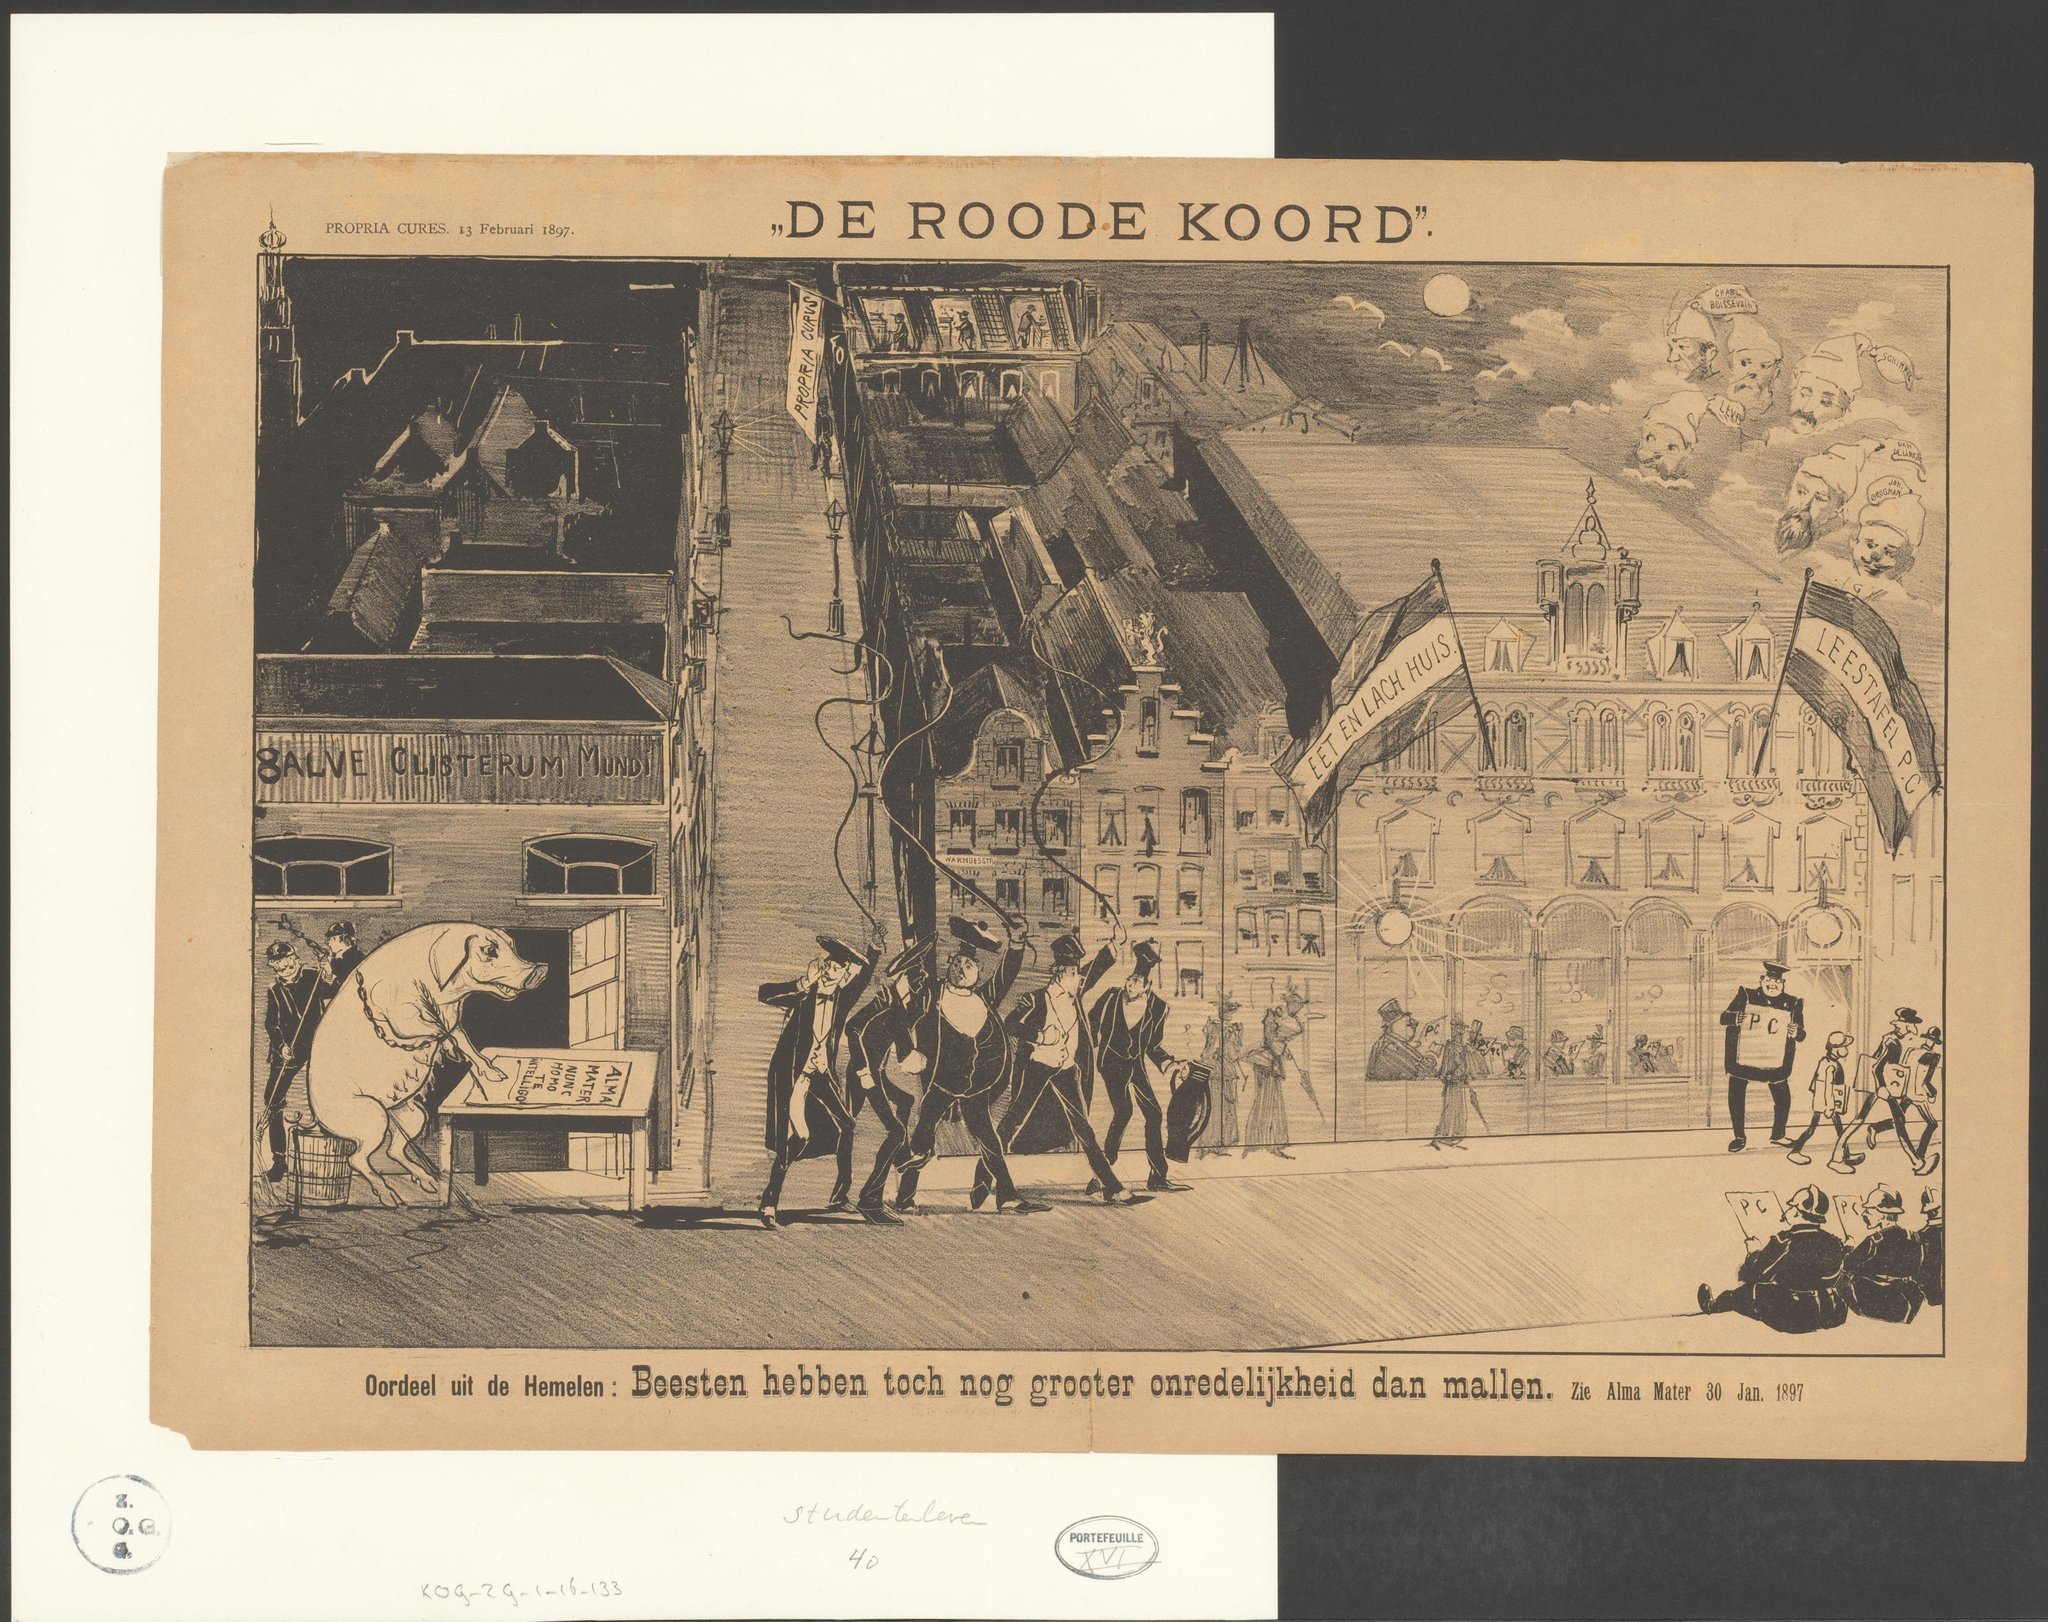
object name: print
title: De Roode Koord, Oordeel uit de Hemelen: Beesten hebben toch nog grooter onredelijkheid dan mallen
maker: Anonymous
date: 1897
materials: paper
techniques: lithograph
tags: university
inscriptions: collector's mark: Lugt 1641, stamp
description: Vier mannen met zwepen lopen over straat. Links een geketend varken dat schrijft: Alma Mater, nu begrijp ik je als man. Onderwerpsrubrieken binnen de Atlas Zeden en Gewoonten: Onderwijs en Wetenschappen, Studentenleven.